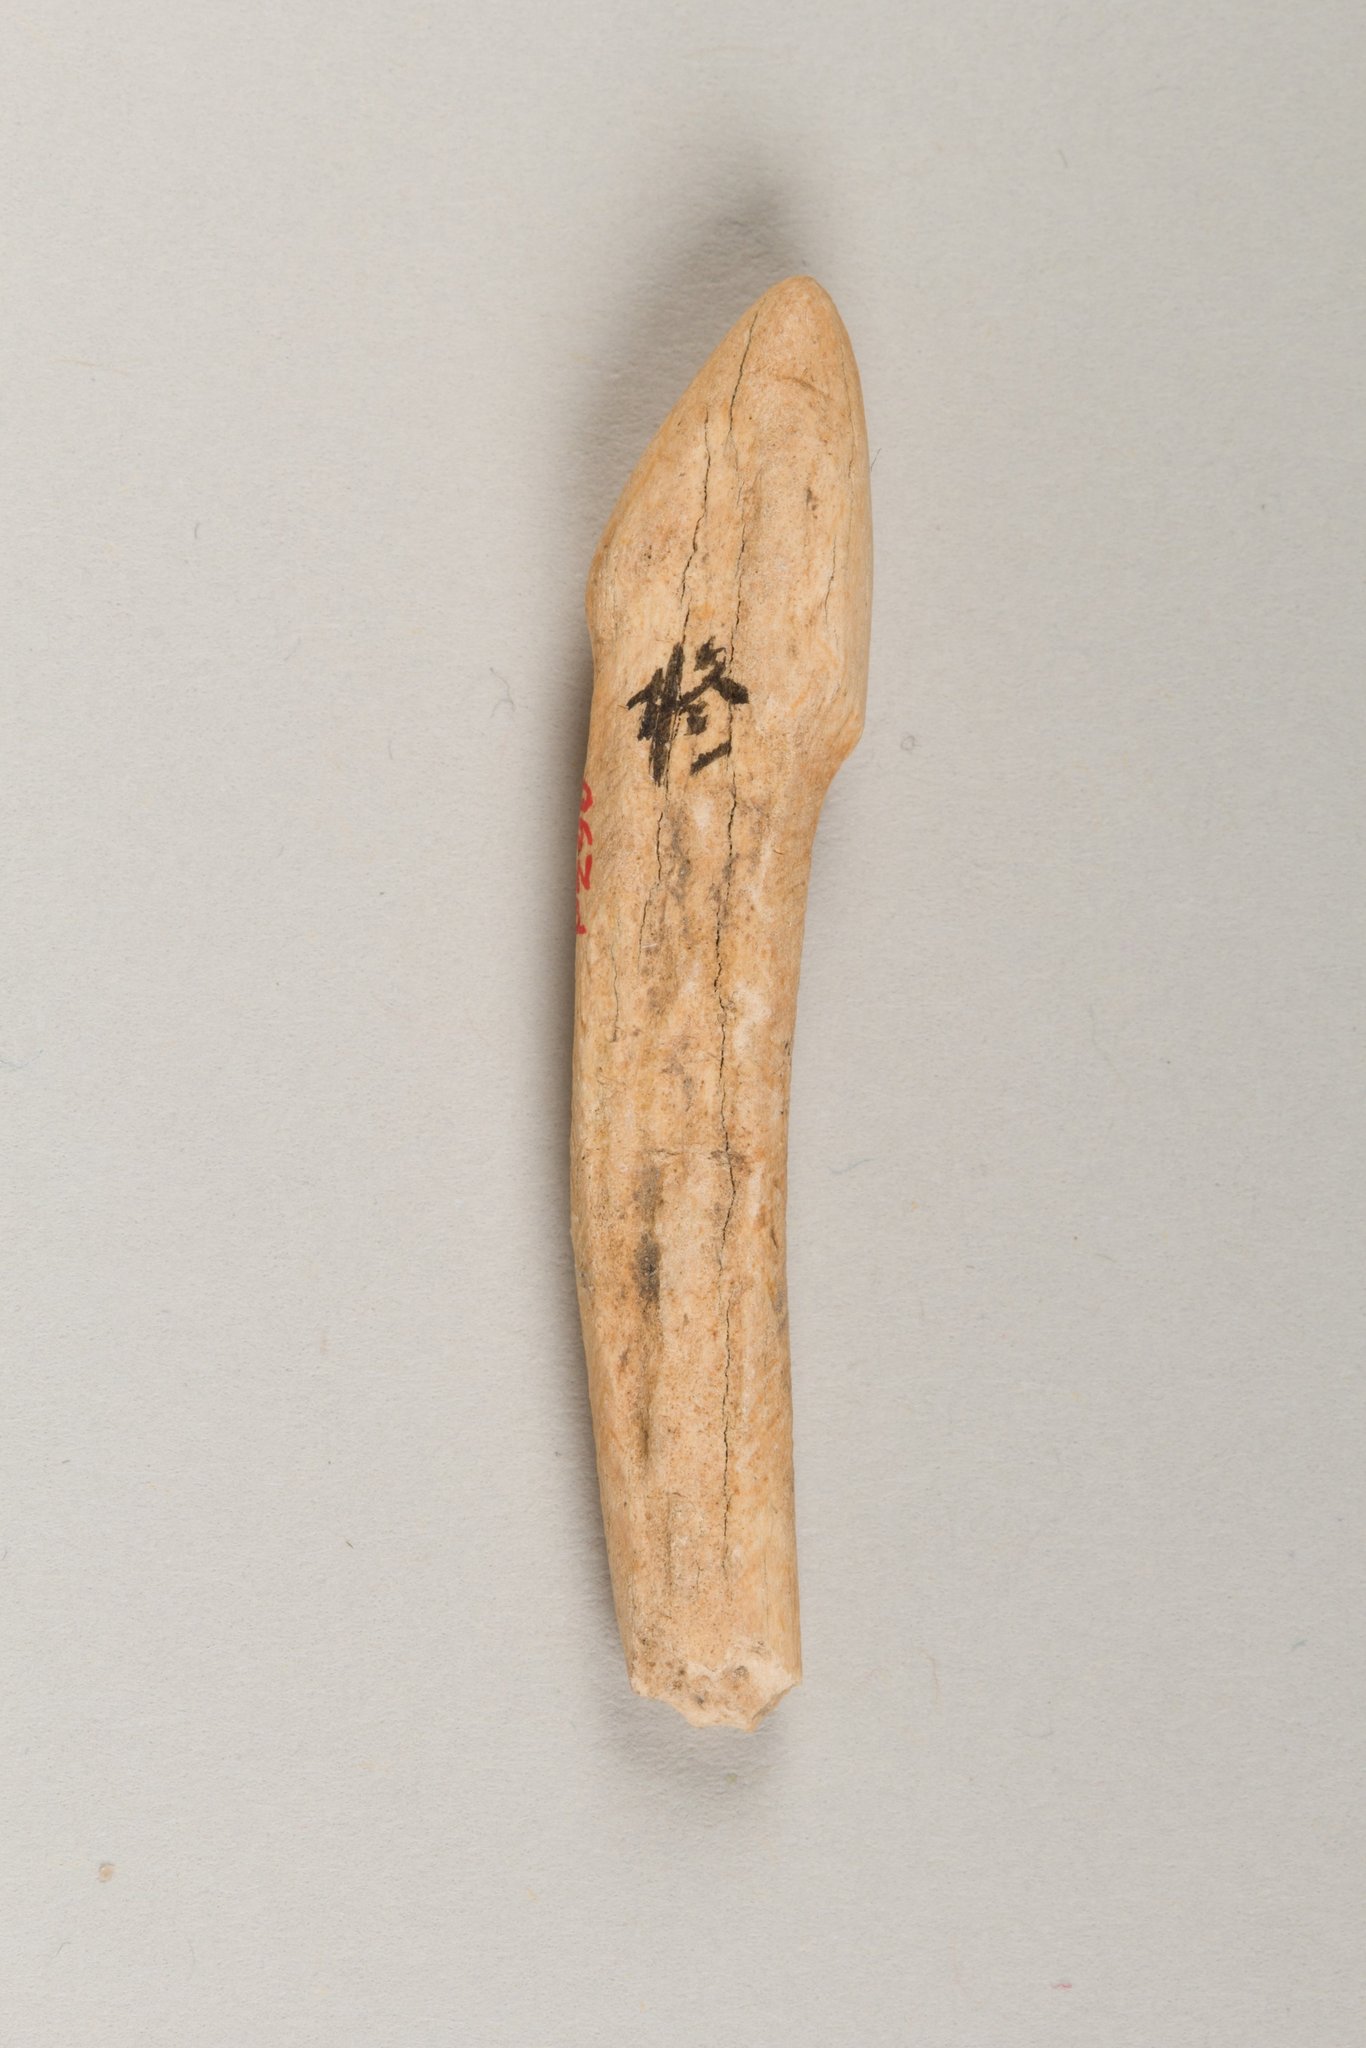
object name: harpoon head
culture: japanese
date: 1000-300 BCE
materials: bone